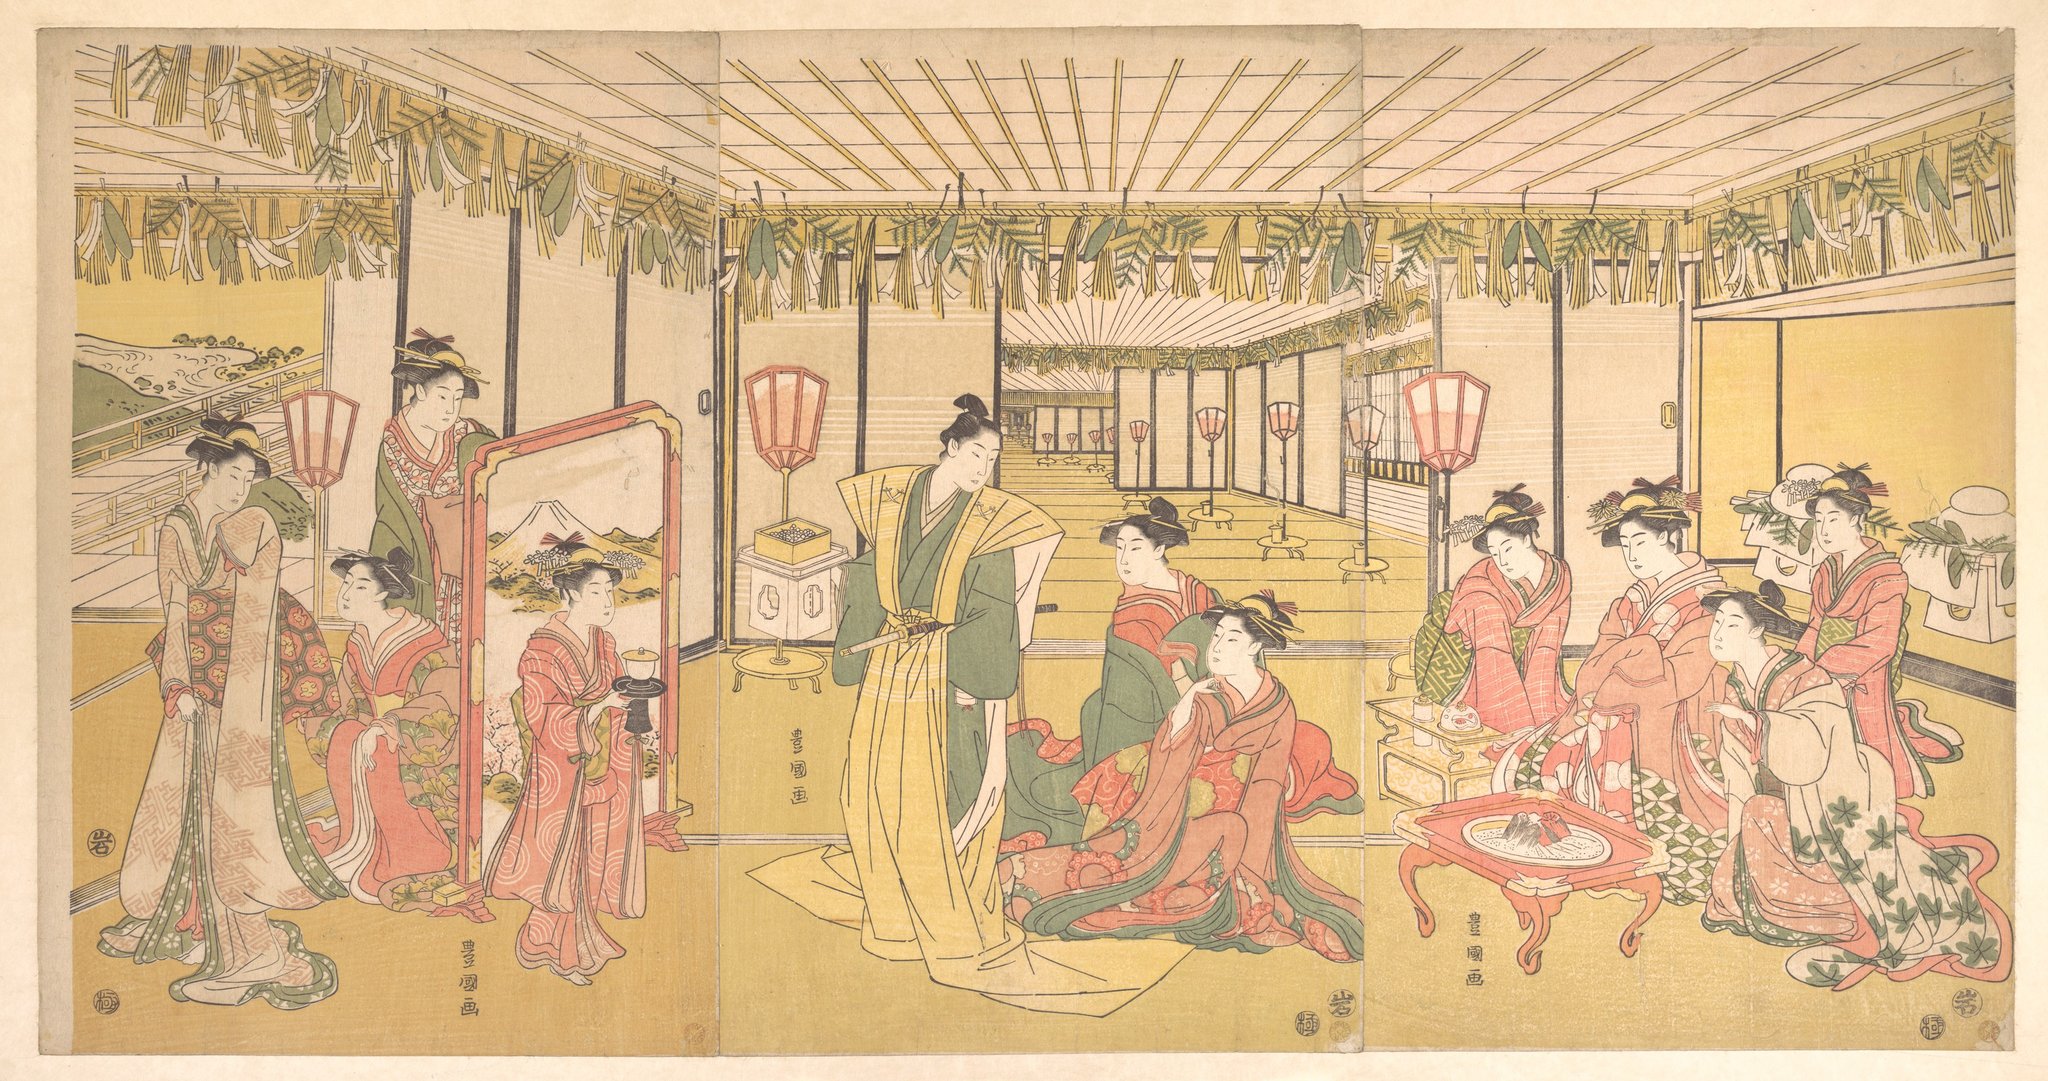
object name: print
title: New Year's Celebration in a Large Mansion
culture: japanese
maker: utagawa toyokuni i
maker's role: artist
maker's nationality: japanese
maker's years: 1769-1825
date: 1791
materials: ink, paper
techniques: woodblock print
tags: interiors,women,party